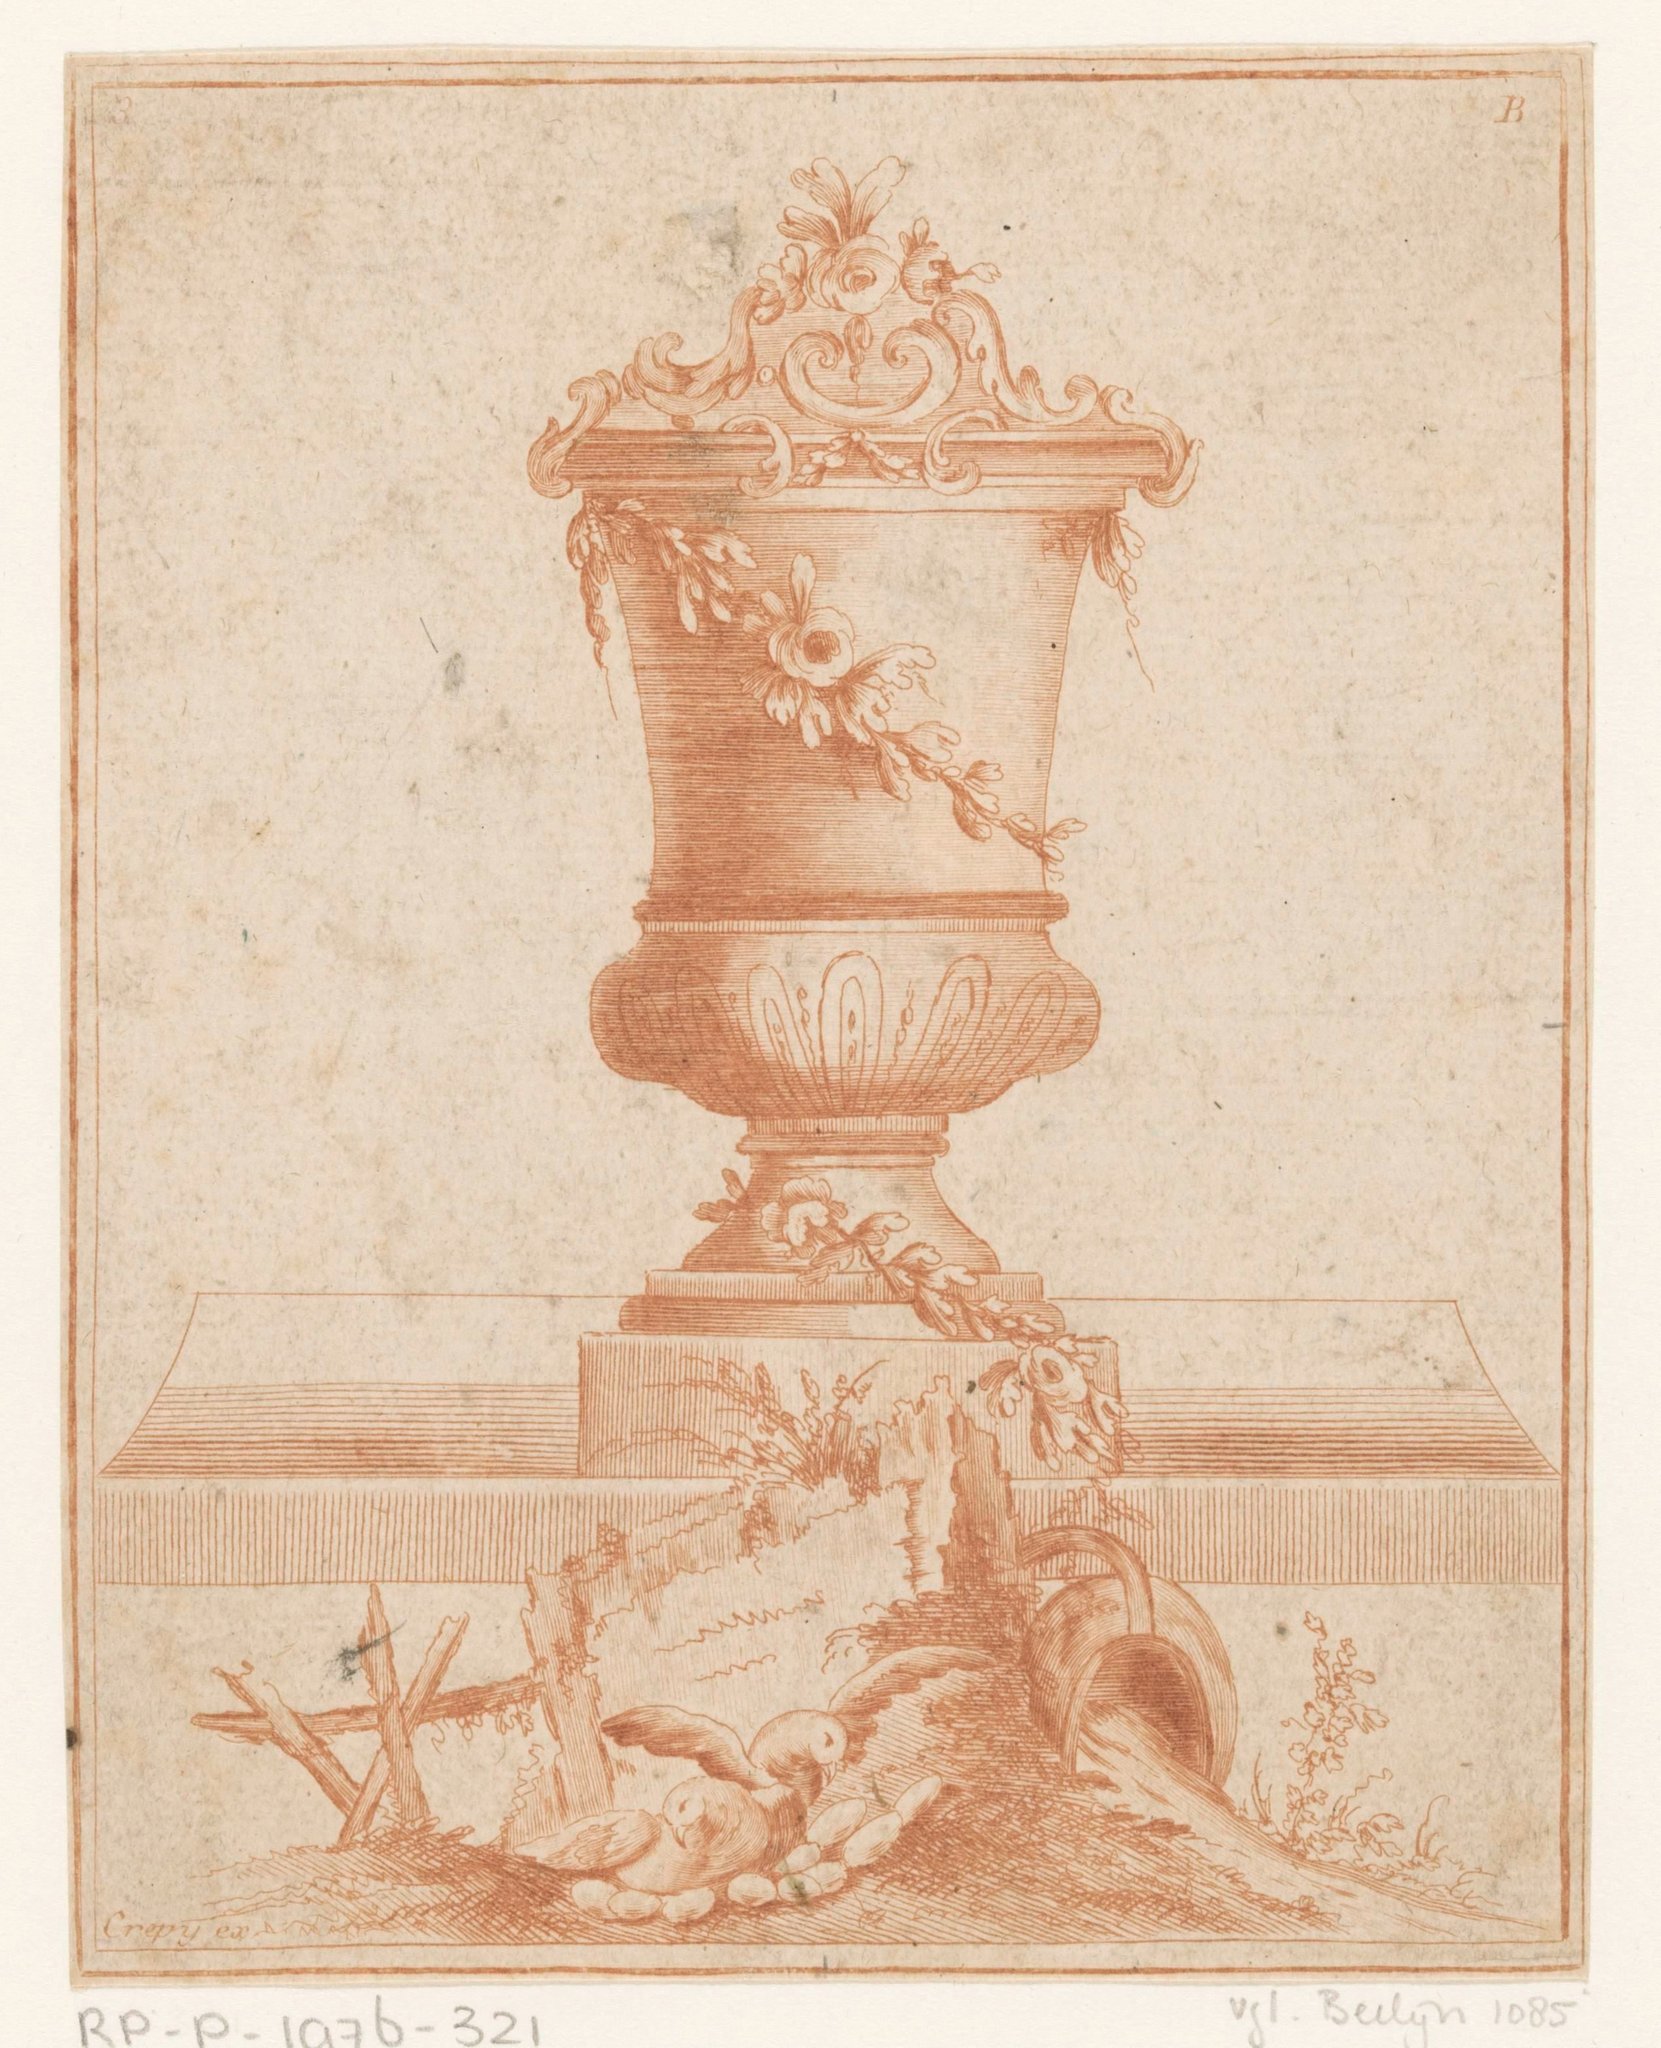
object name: ornament print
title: Vaas met bloemen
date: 1770-1780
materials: paper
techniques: etching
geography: paris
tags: vase ~ ornament, flowers ~ ornament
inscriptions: collector's mark: Lugt 2228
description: Een geornamenteerde vaas met bloemen. Daaronder een waterkan en broedende vogels.